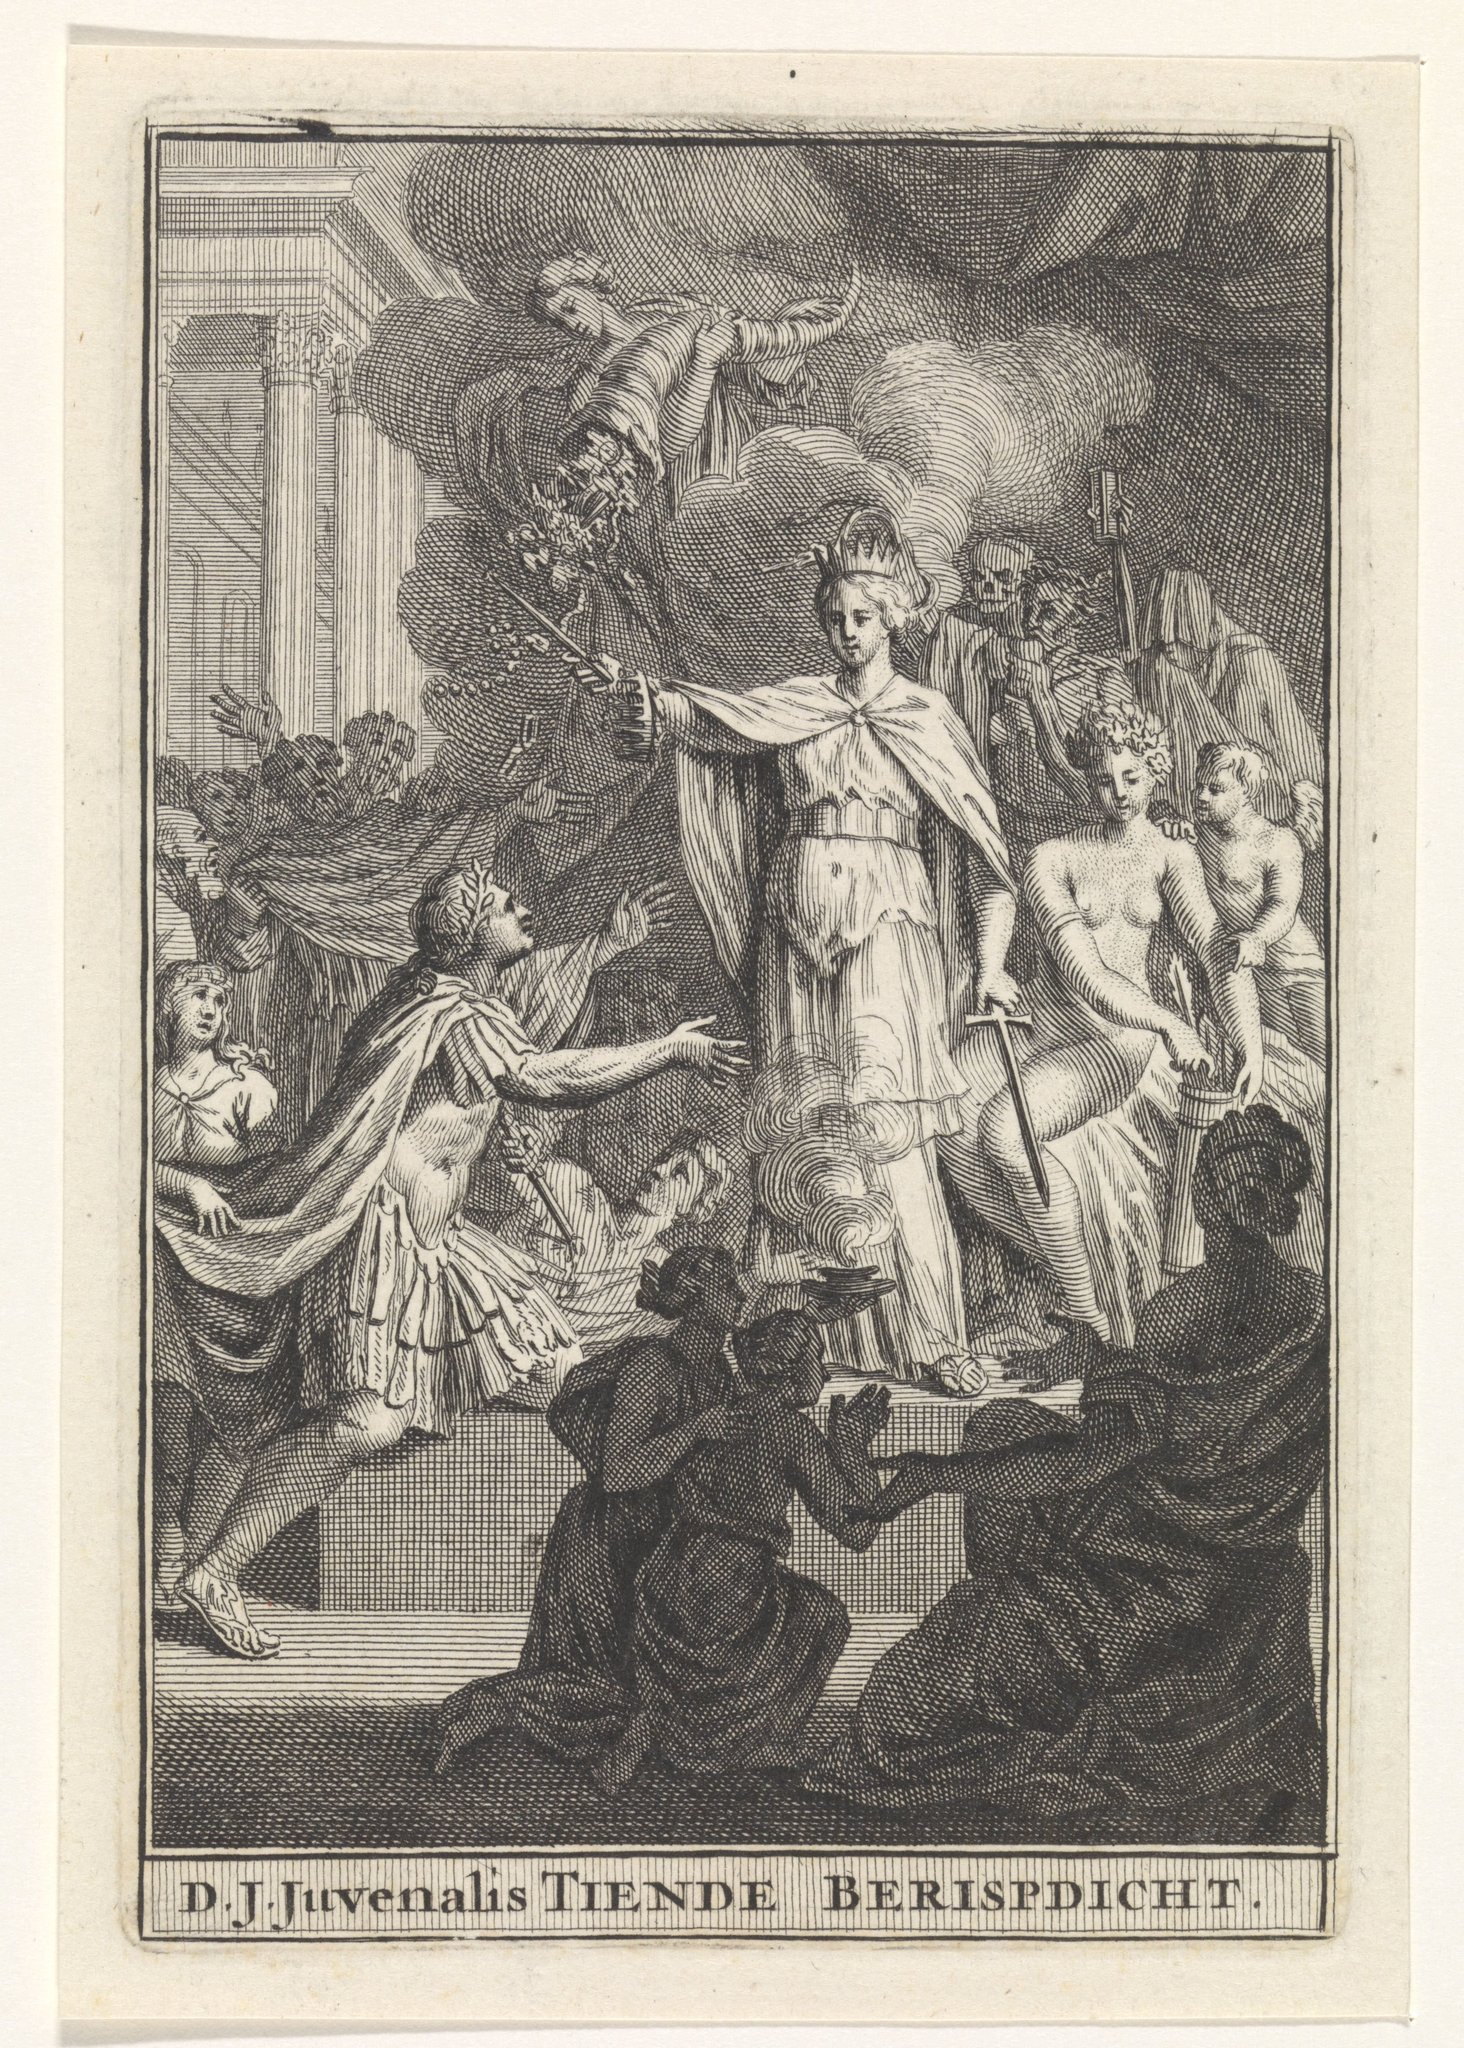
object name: print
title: De dichter Juvenalis knielt voor Melpomene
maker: bernard picart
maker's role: draughtsman, print maker, publisher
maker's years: 1673-1733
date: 1711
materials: paper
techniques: engraving, etching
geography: amsterdam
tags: 'cornucopia', horn of plenty, envy; 'invidia' (ripa) ~ personification of one of the seven deadly sins, death as skeleton, (story of) cupid, amor (eros), (story of) venus (aphrodite), writer, poet, author, melpomene (one of the muses); 'melpomene' (ripa)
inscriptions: collector's mark: Lugt 2228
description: De dichter Juvenalis knielt voor Melpomene, de muze van het treurspel. Rechts op de achtergrond Venus en Amor, de Dood, Afgunst en een gesluierde vrouw. Vanuit de hemel kiepert een vrouw de inhoud van een hoorn des overvloeds op de dichter. Omstanders kijken toe. In de marge de titel in het Nederlands.